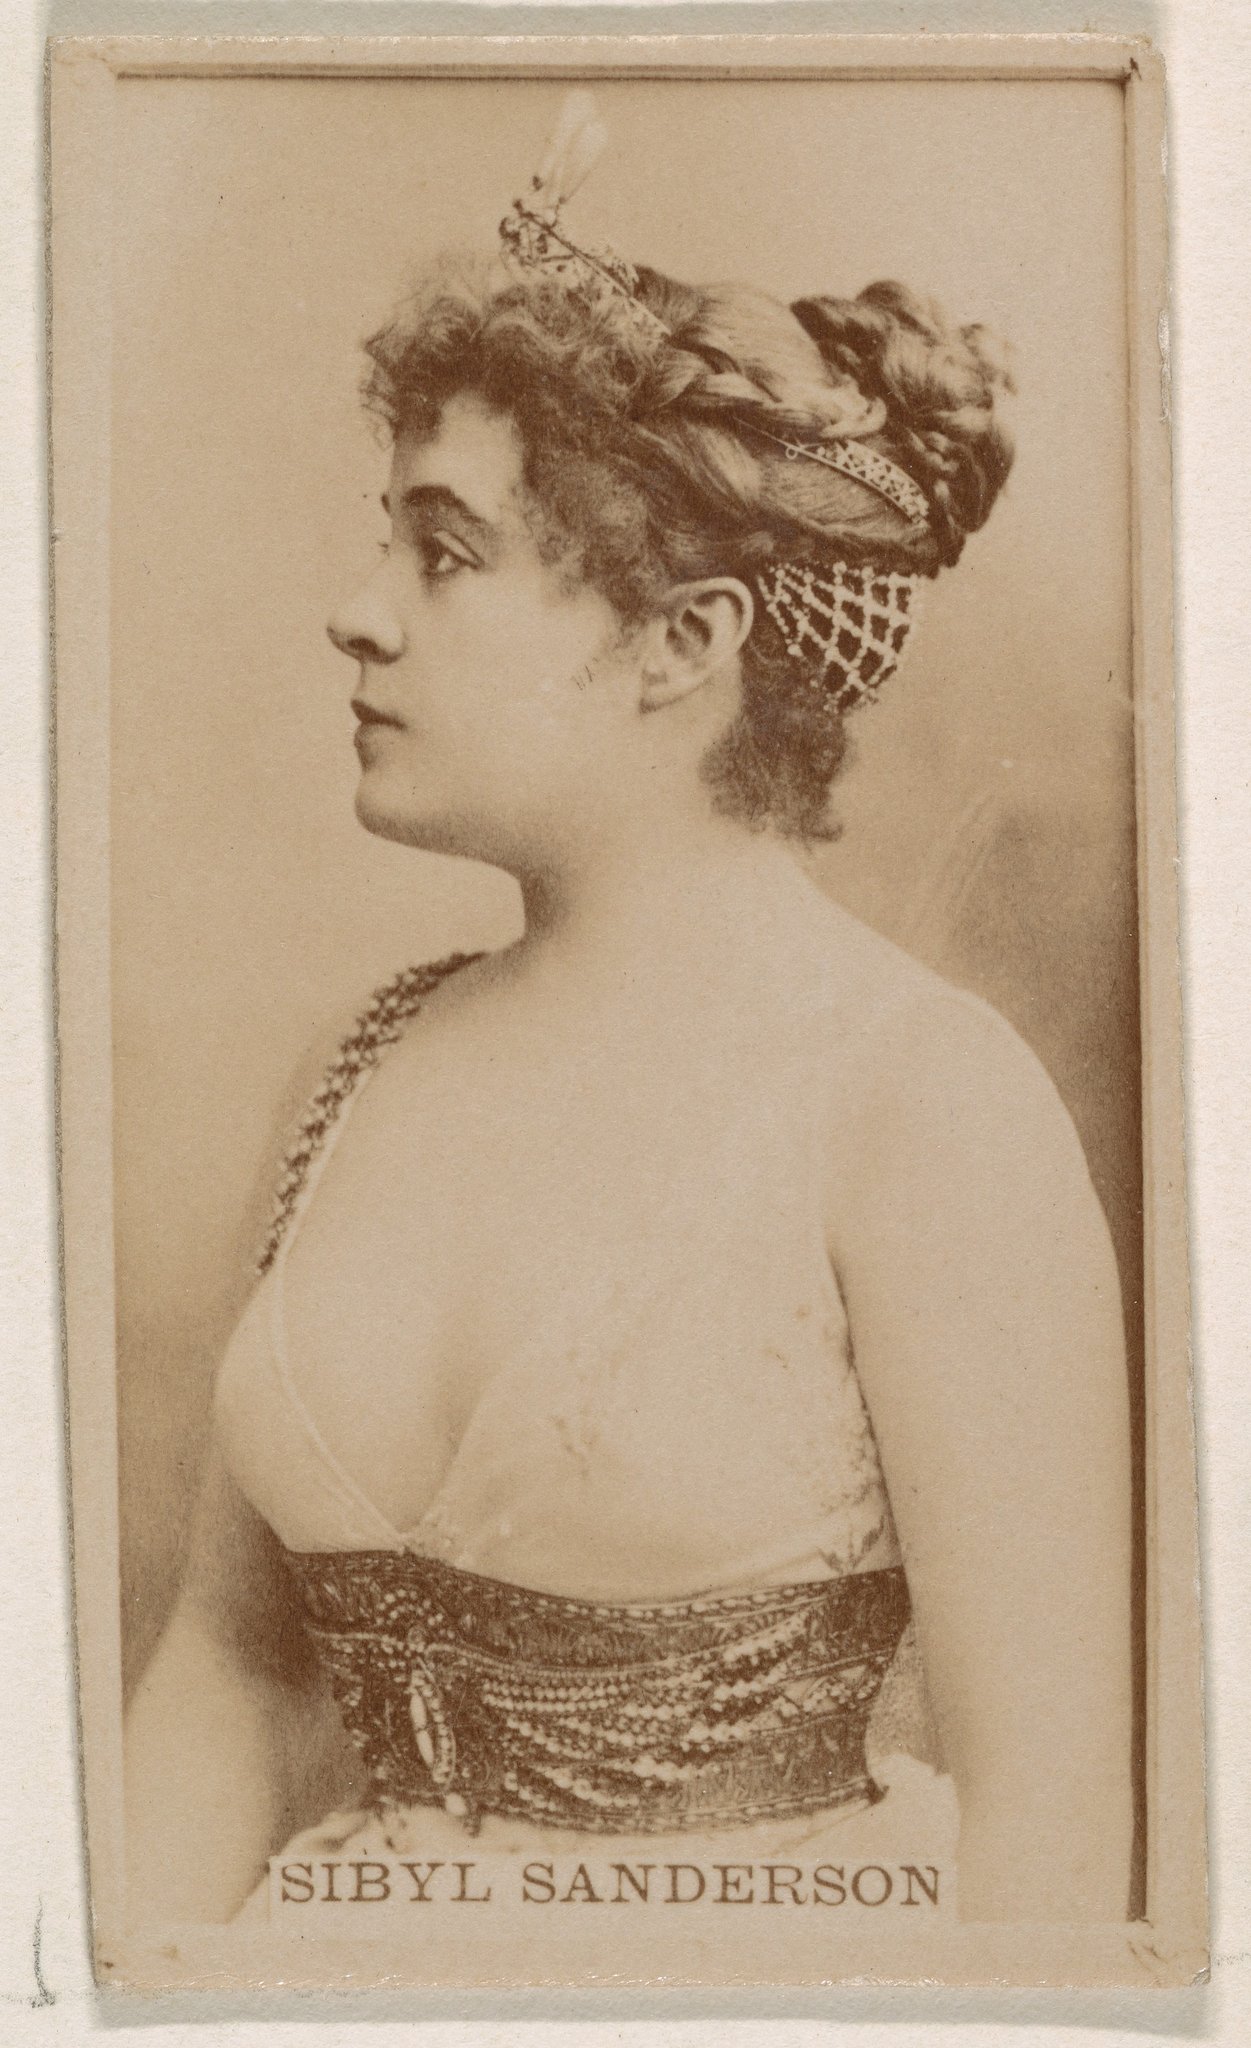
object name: photograph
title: Sibyl Anderson, from the Actresses series (N245) issued by Kinney Brothers to promote Sweet Caporal Cigarettes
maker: kinney brothers tobacco company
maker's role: publisher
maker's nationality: american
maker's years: 1869-2011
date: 1890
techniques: albumen silver print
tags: women,actresses